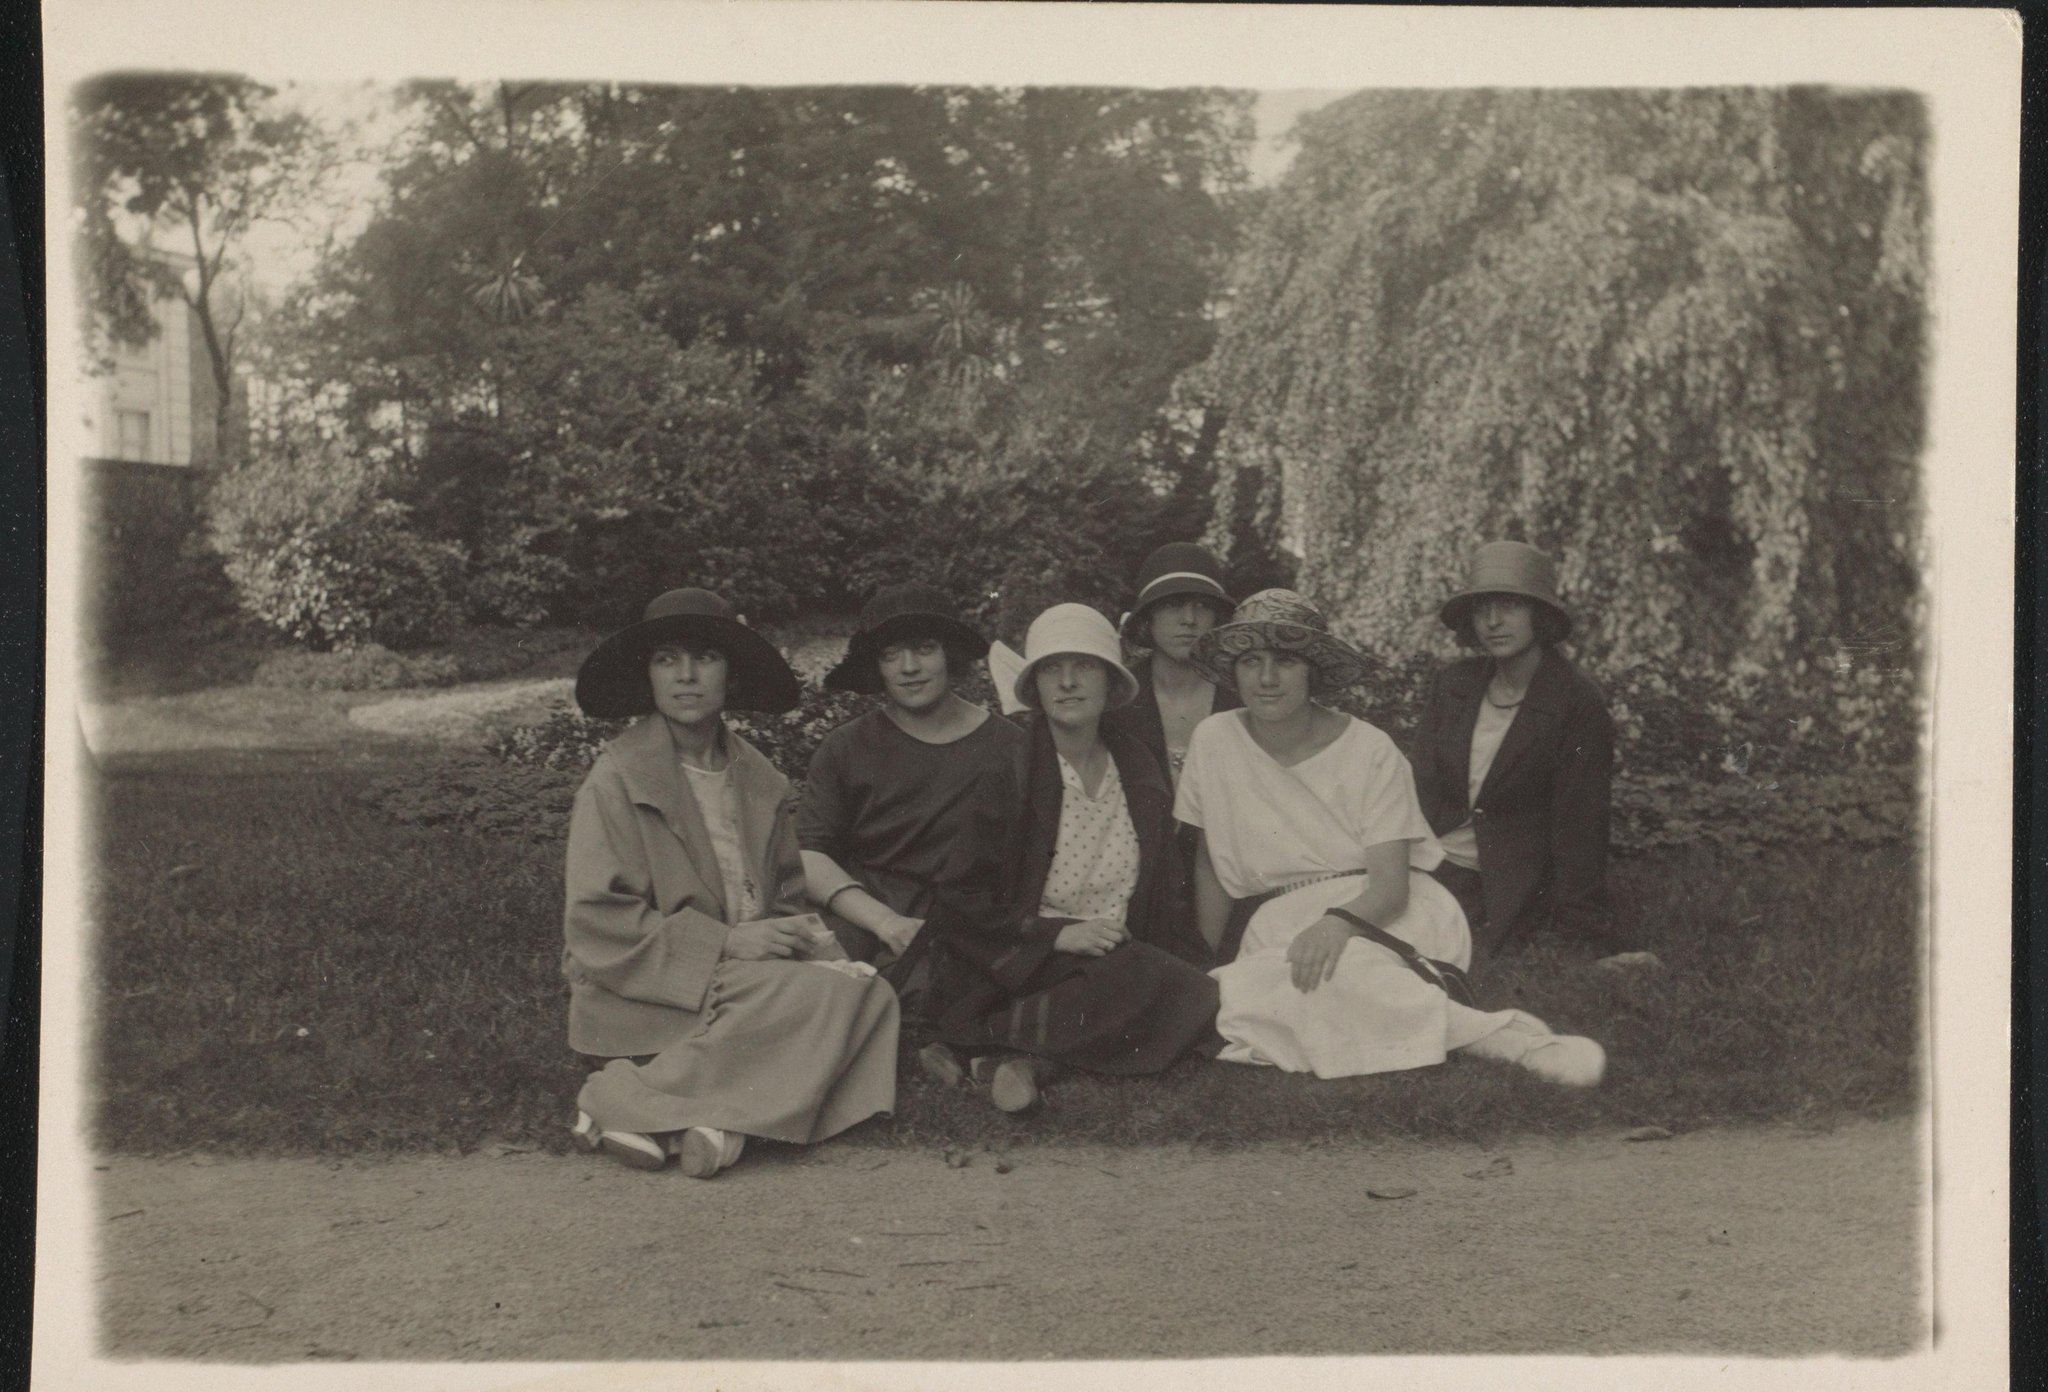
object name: photograph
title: Groepsportret van zes vrouwen met hoeden zittend in de tuin van het Palais des Académies in Brussel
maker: Anonymous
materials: photographic support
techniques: gelatin silver print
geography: brussels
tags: head-gear: hat, brussels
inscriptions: inscription: ‘Palais des Académies Eté 1923 Royale Belges Colleg[...]’